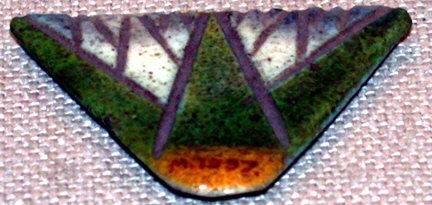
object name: inlay, lotus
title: Lotus Inlay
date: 1353-1323 BCE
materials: faience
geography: egypt